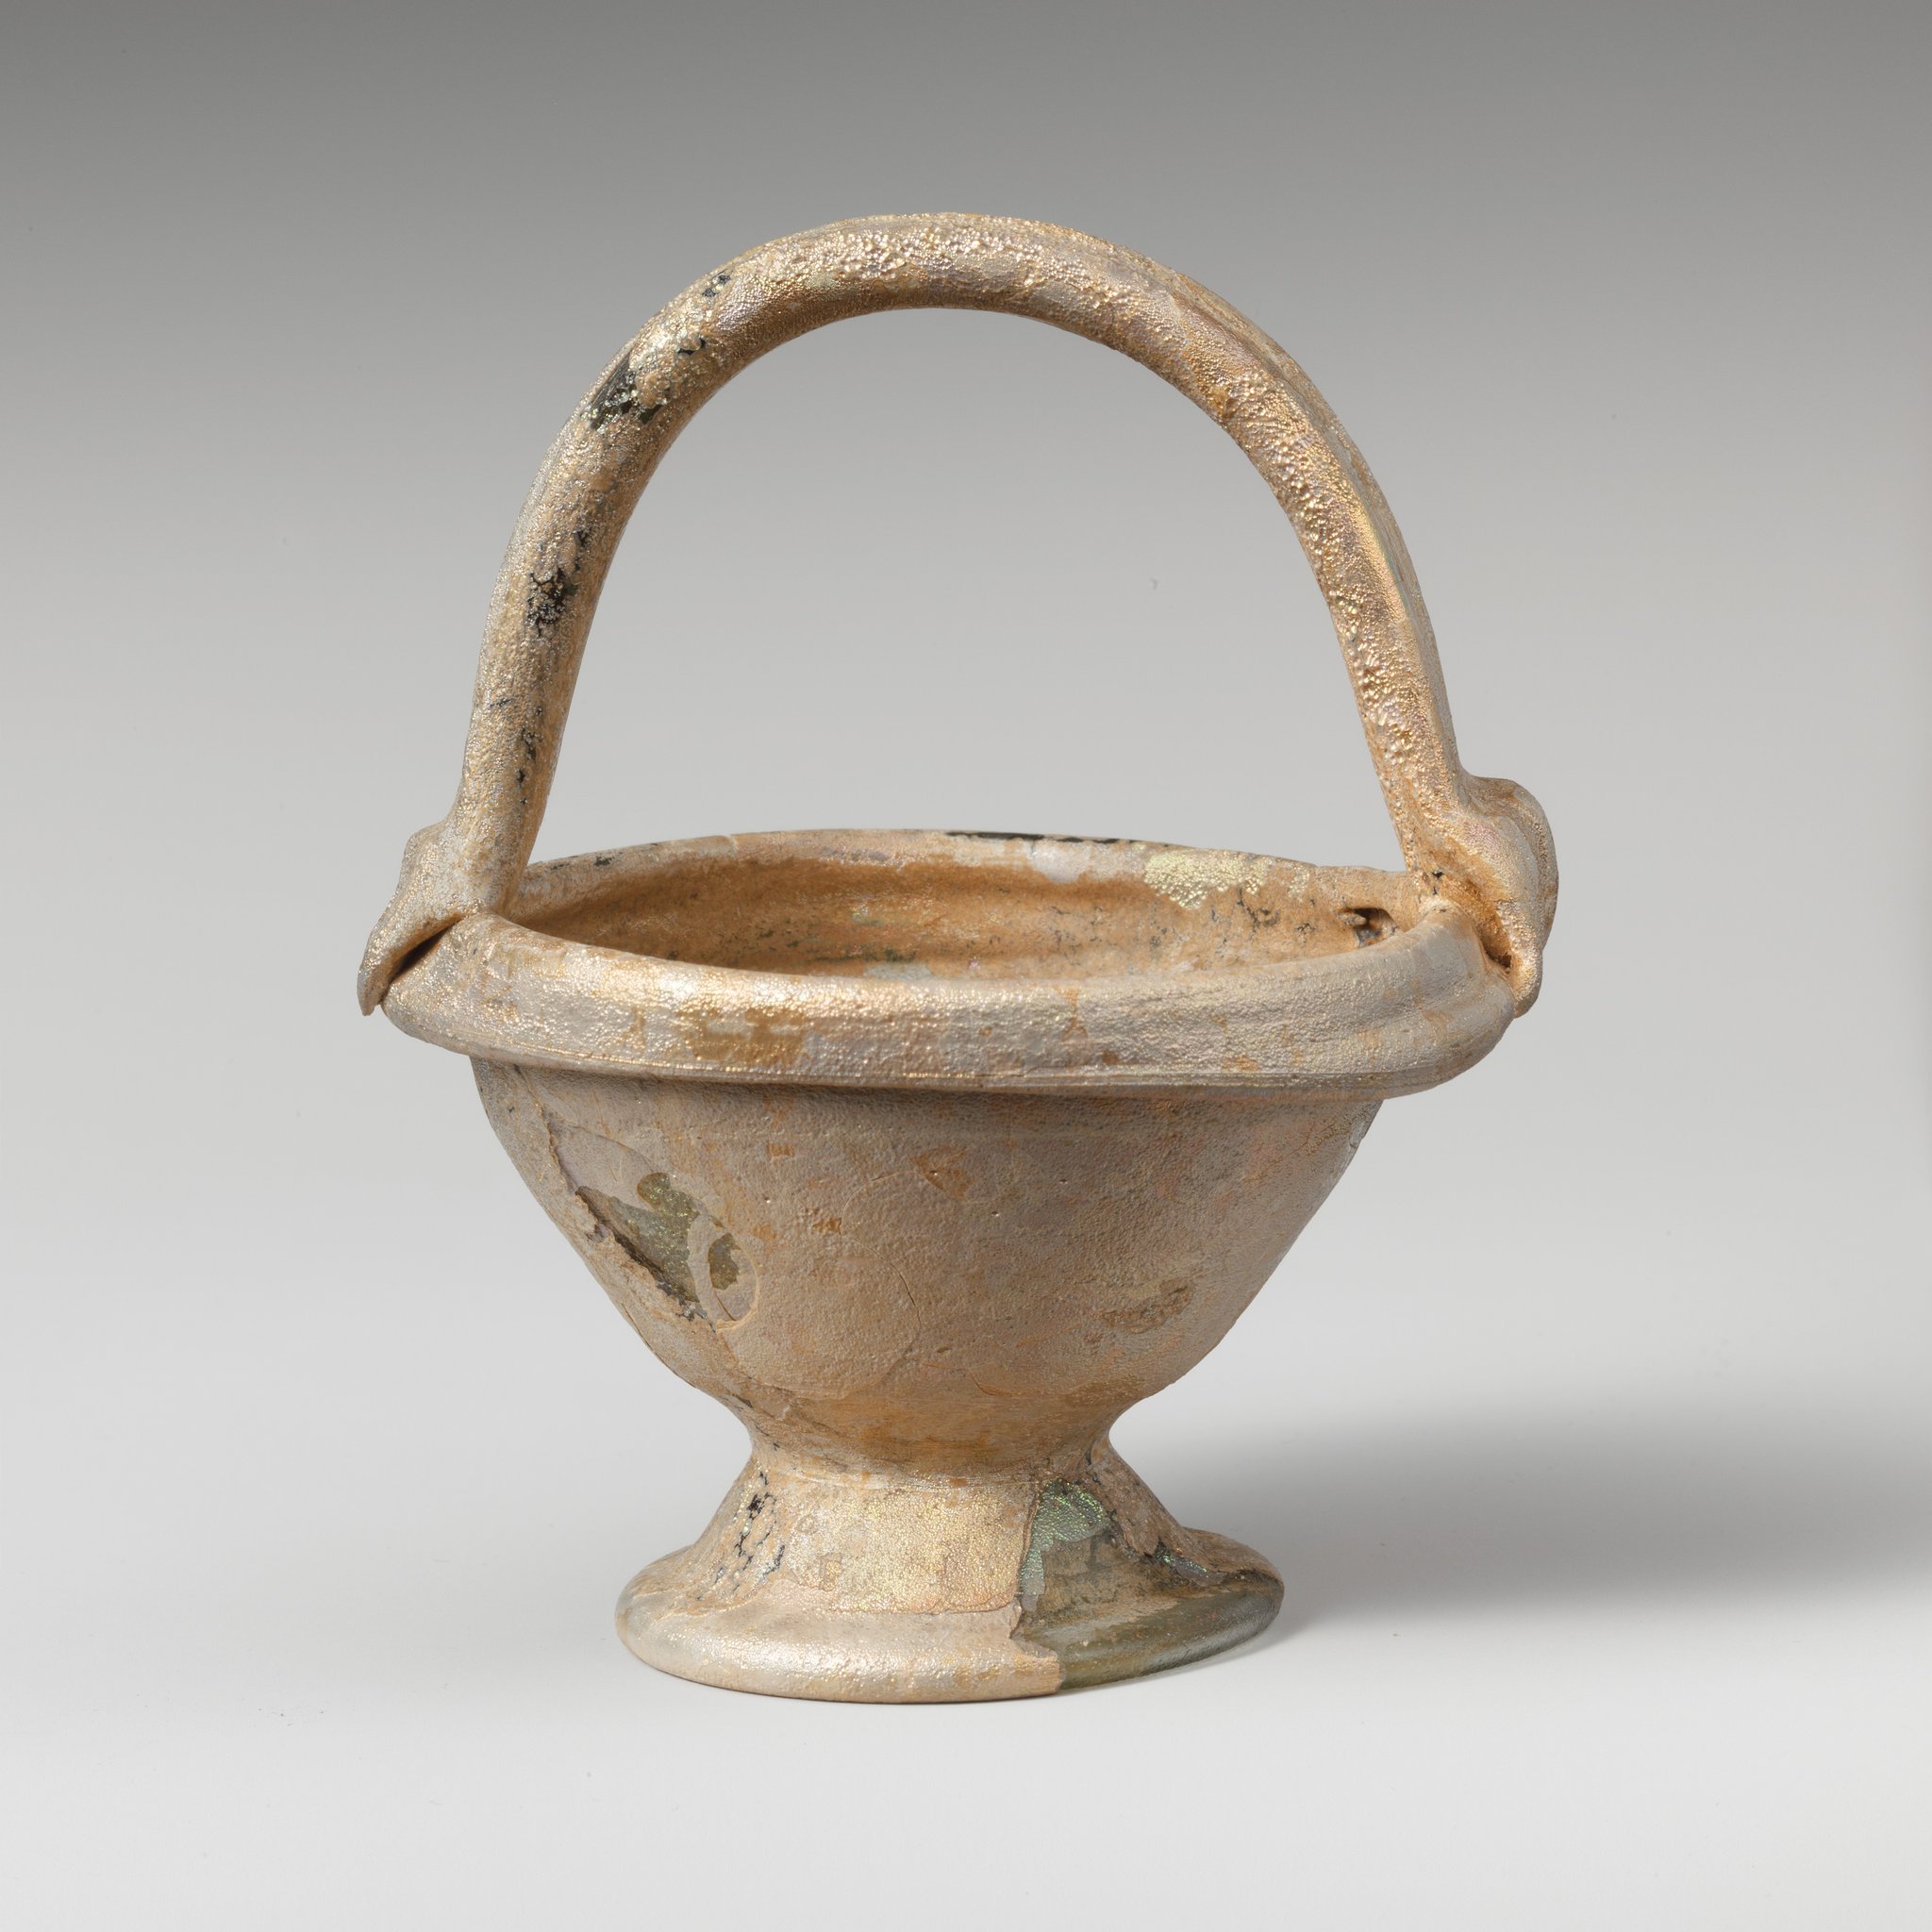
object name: handle of a bowl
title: Glass bowl with basket handle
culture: roman, syrian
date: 301-400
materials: glass